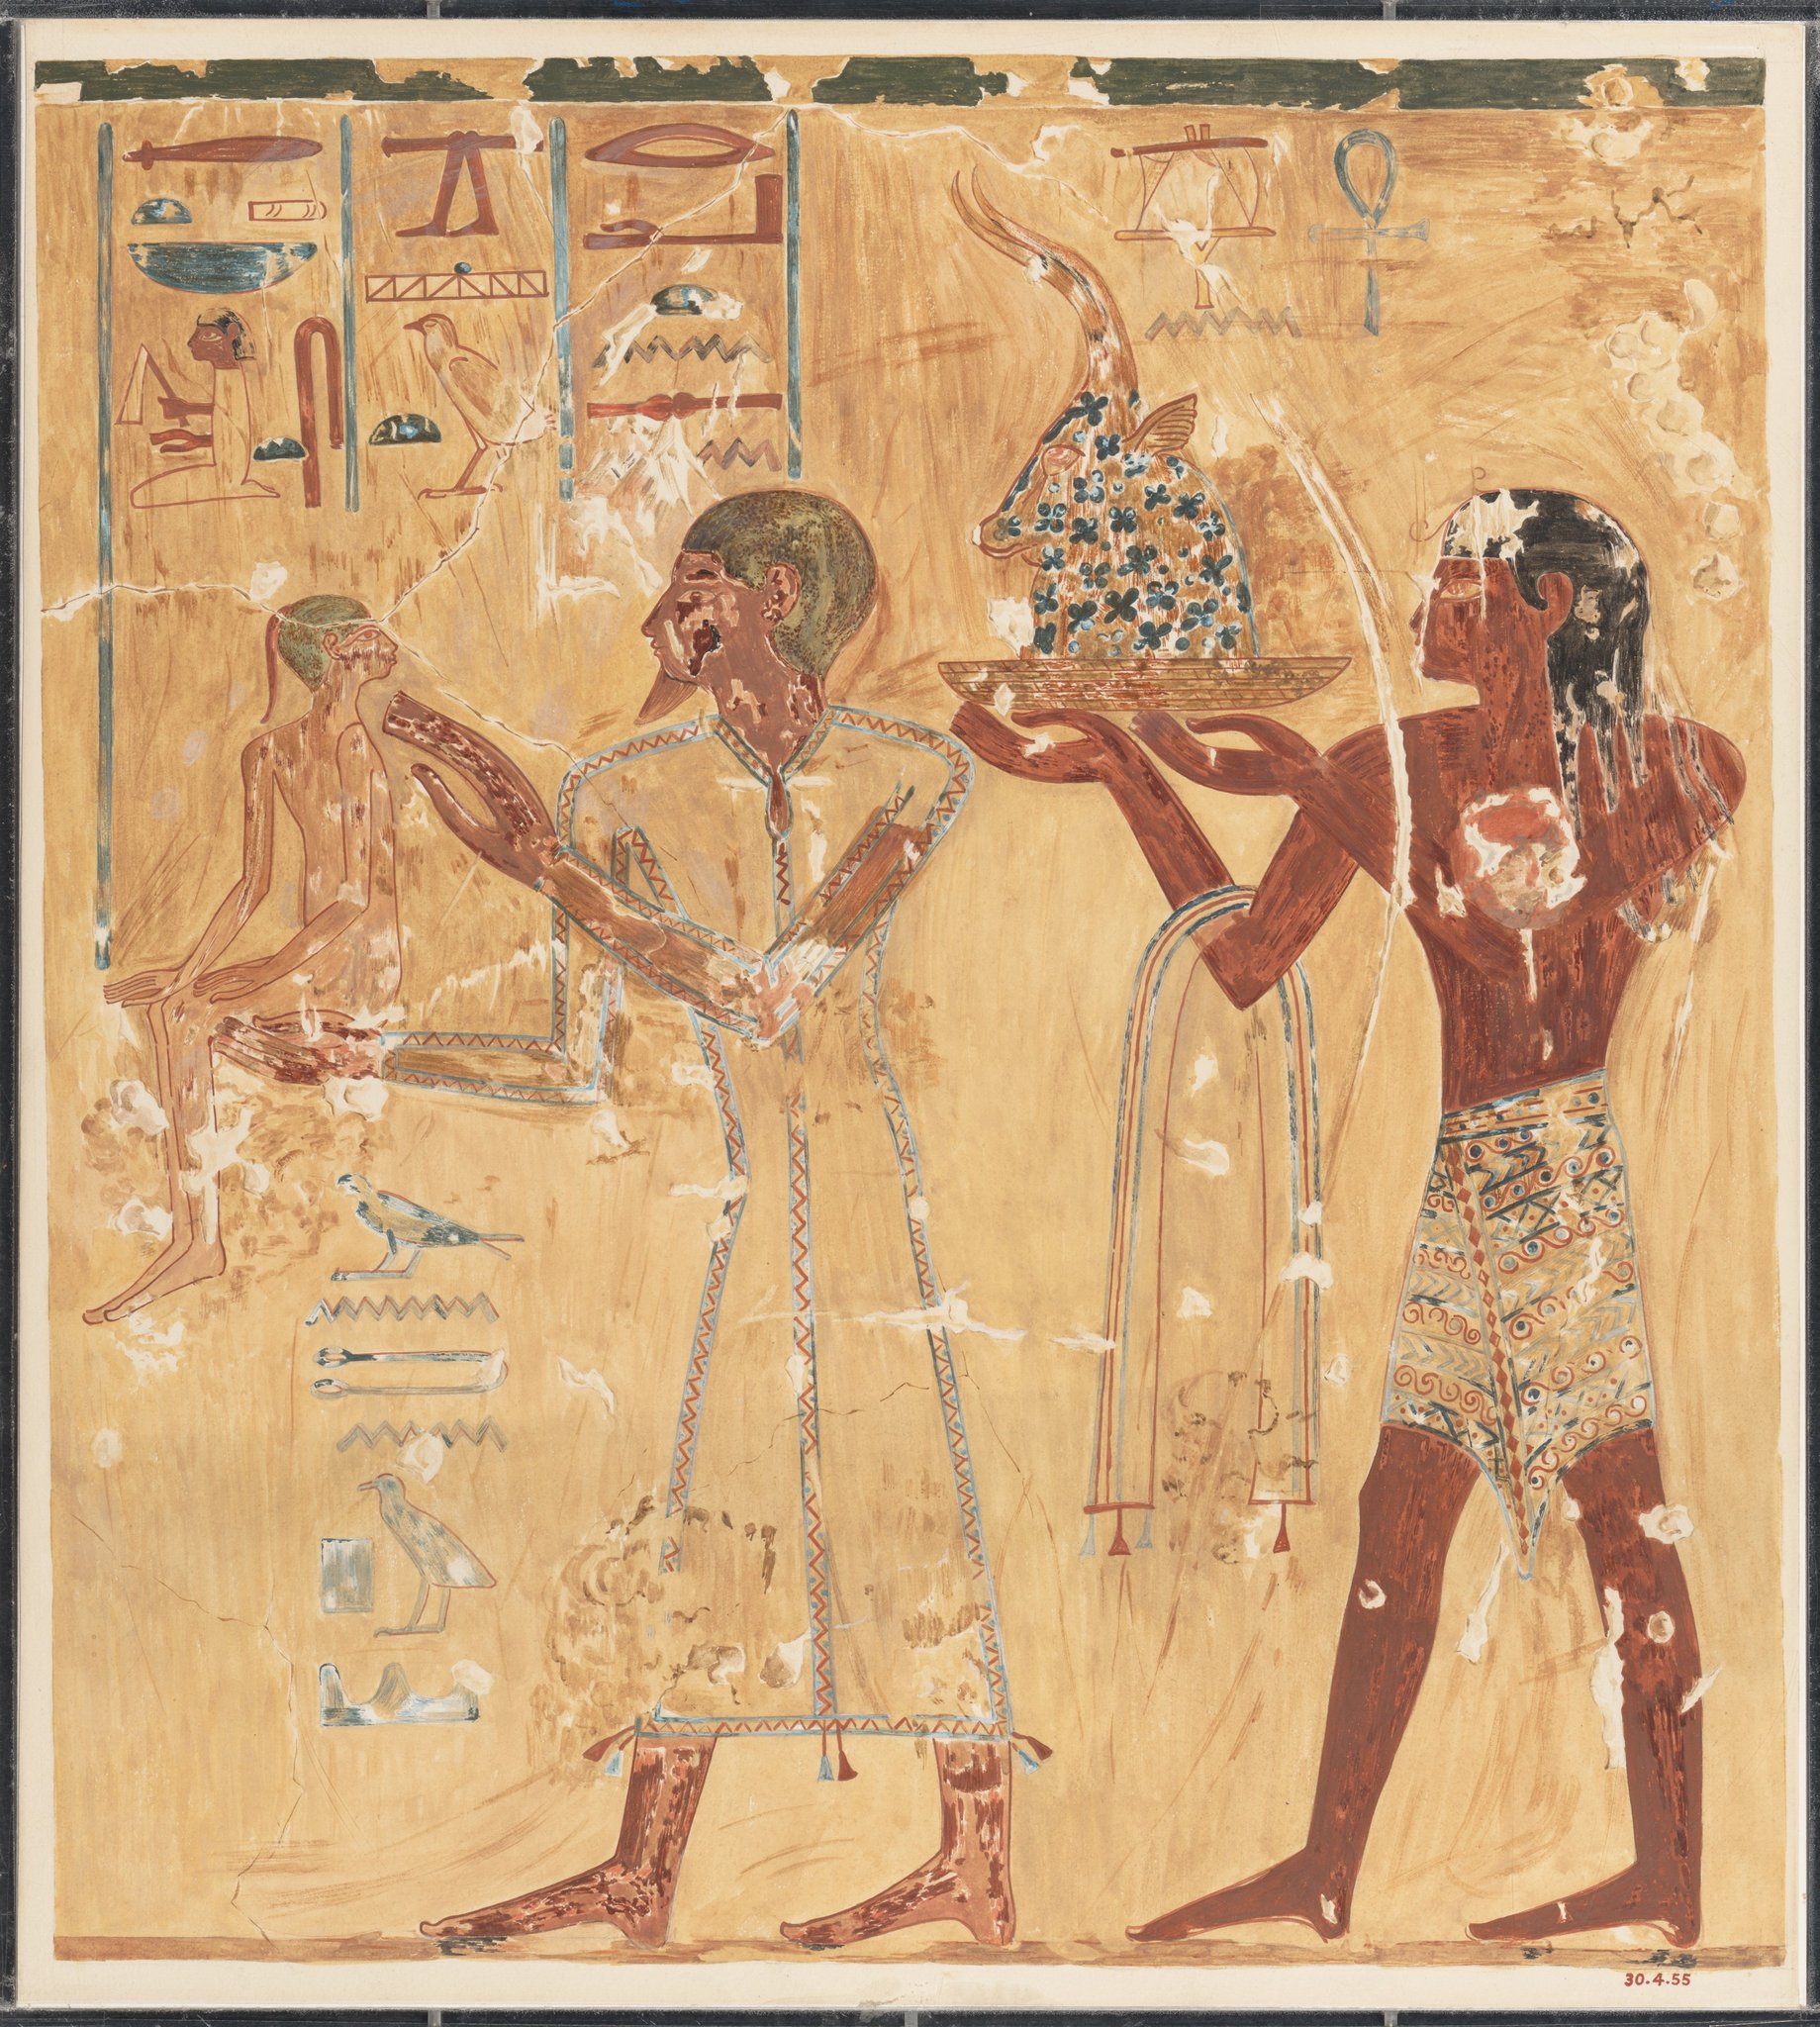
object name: facsimile, menkheperraseneb tt 86, asian, keftiu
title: Foreigners, Tomb of Menkheperraseneb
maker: nina de garis davies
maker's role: artist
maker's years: 1881-1965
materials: paper, paint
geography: egypt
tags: men,hieroglyphs